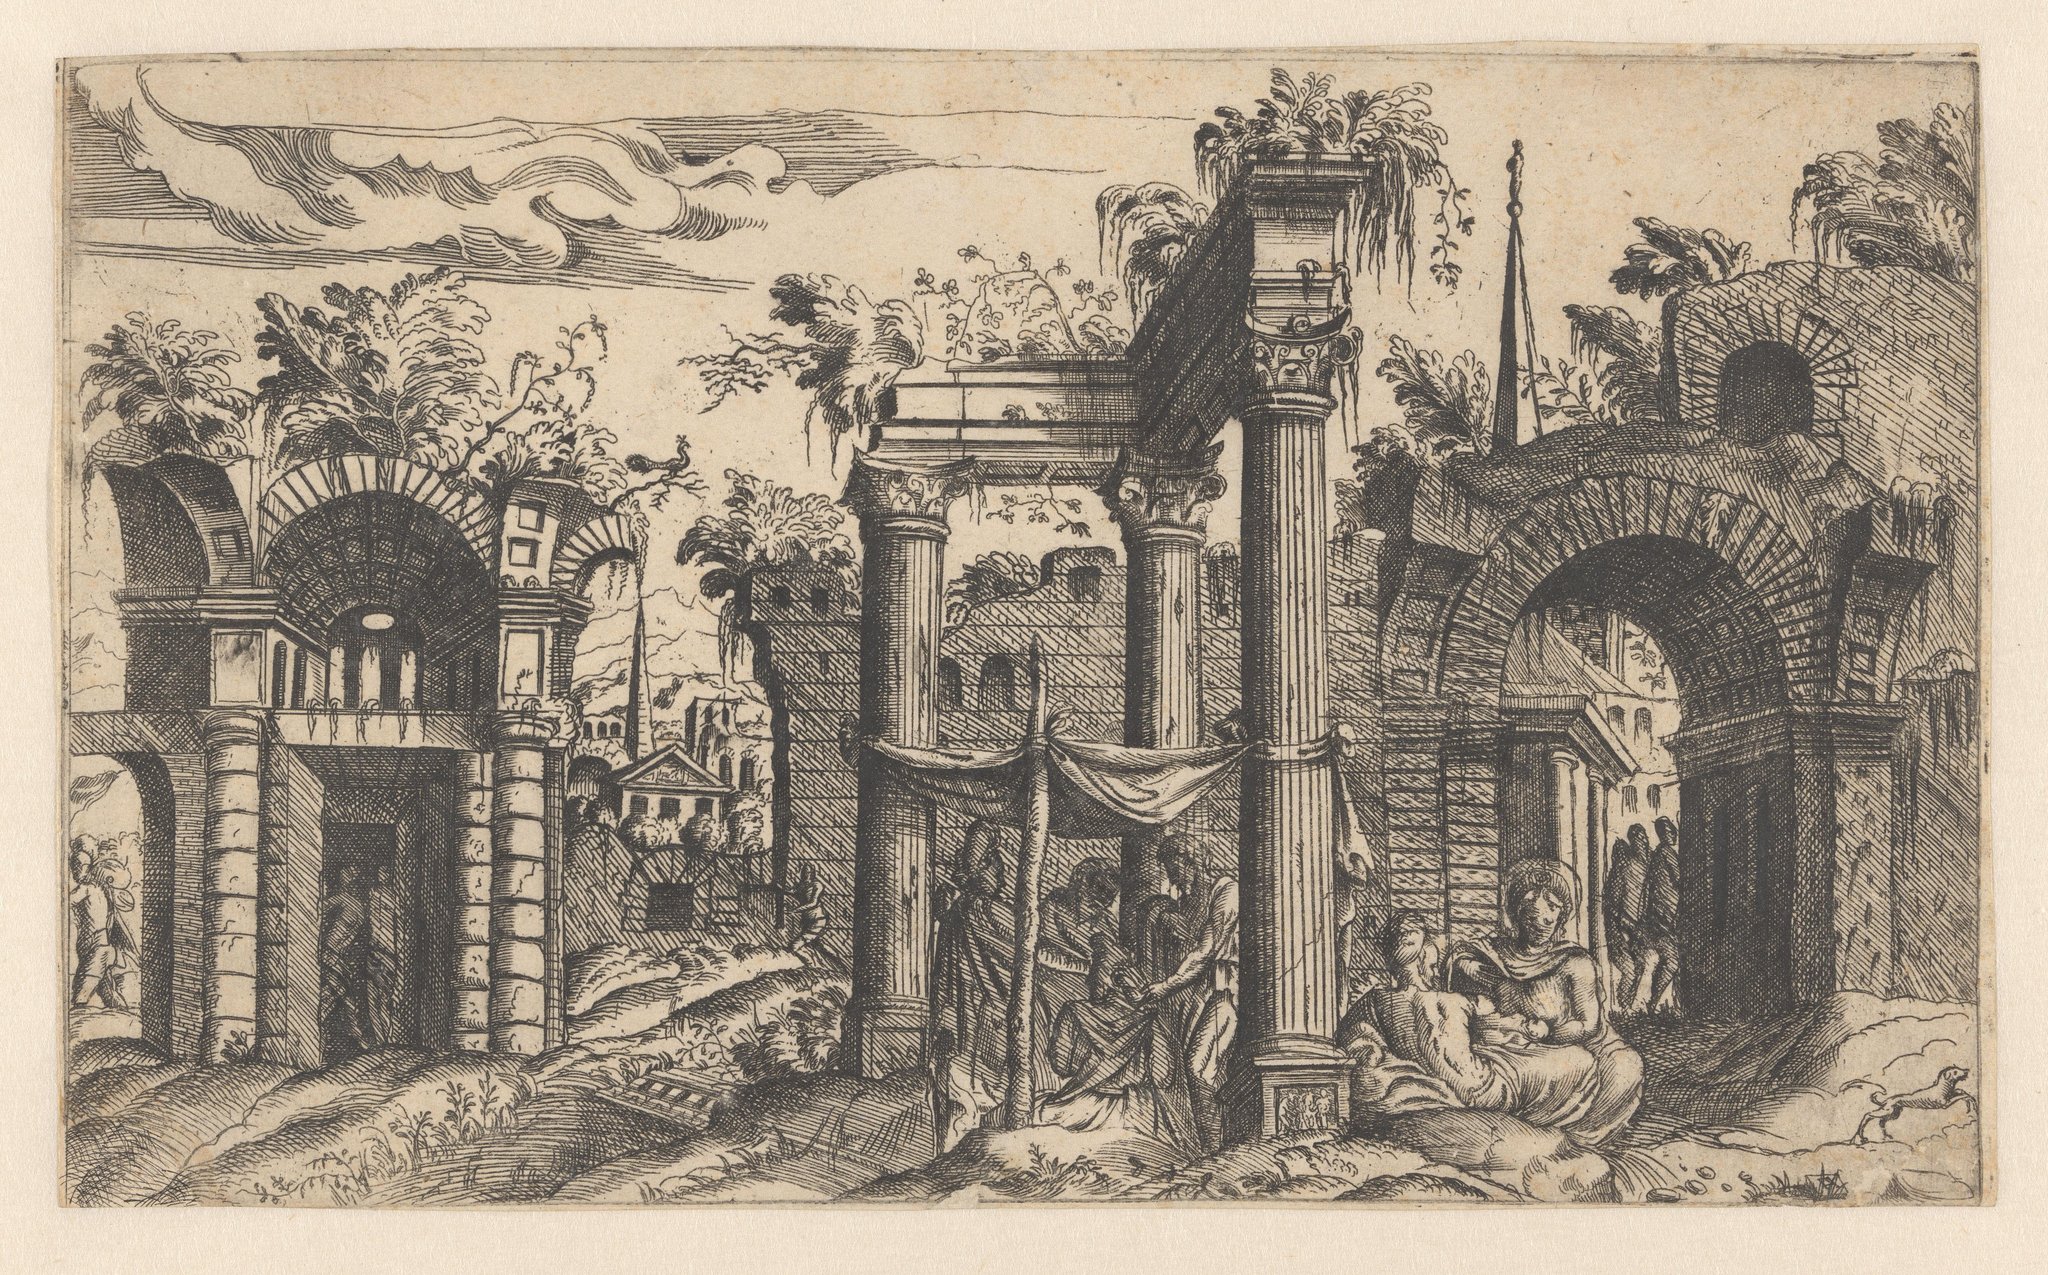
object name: print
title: Ruïne landschap met de Heilige Familie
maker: Anonymous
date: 1560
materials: paper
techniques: etching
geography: italy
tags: rest on the flight into egypt, landscape with ruins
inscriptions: collector's mark: Lugt 2760, collector's mark: Lugt 845, collector's mark: Lugt 2228, collector's mark